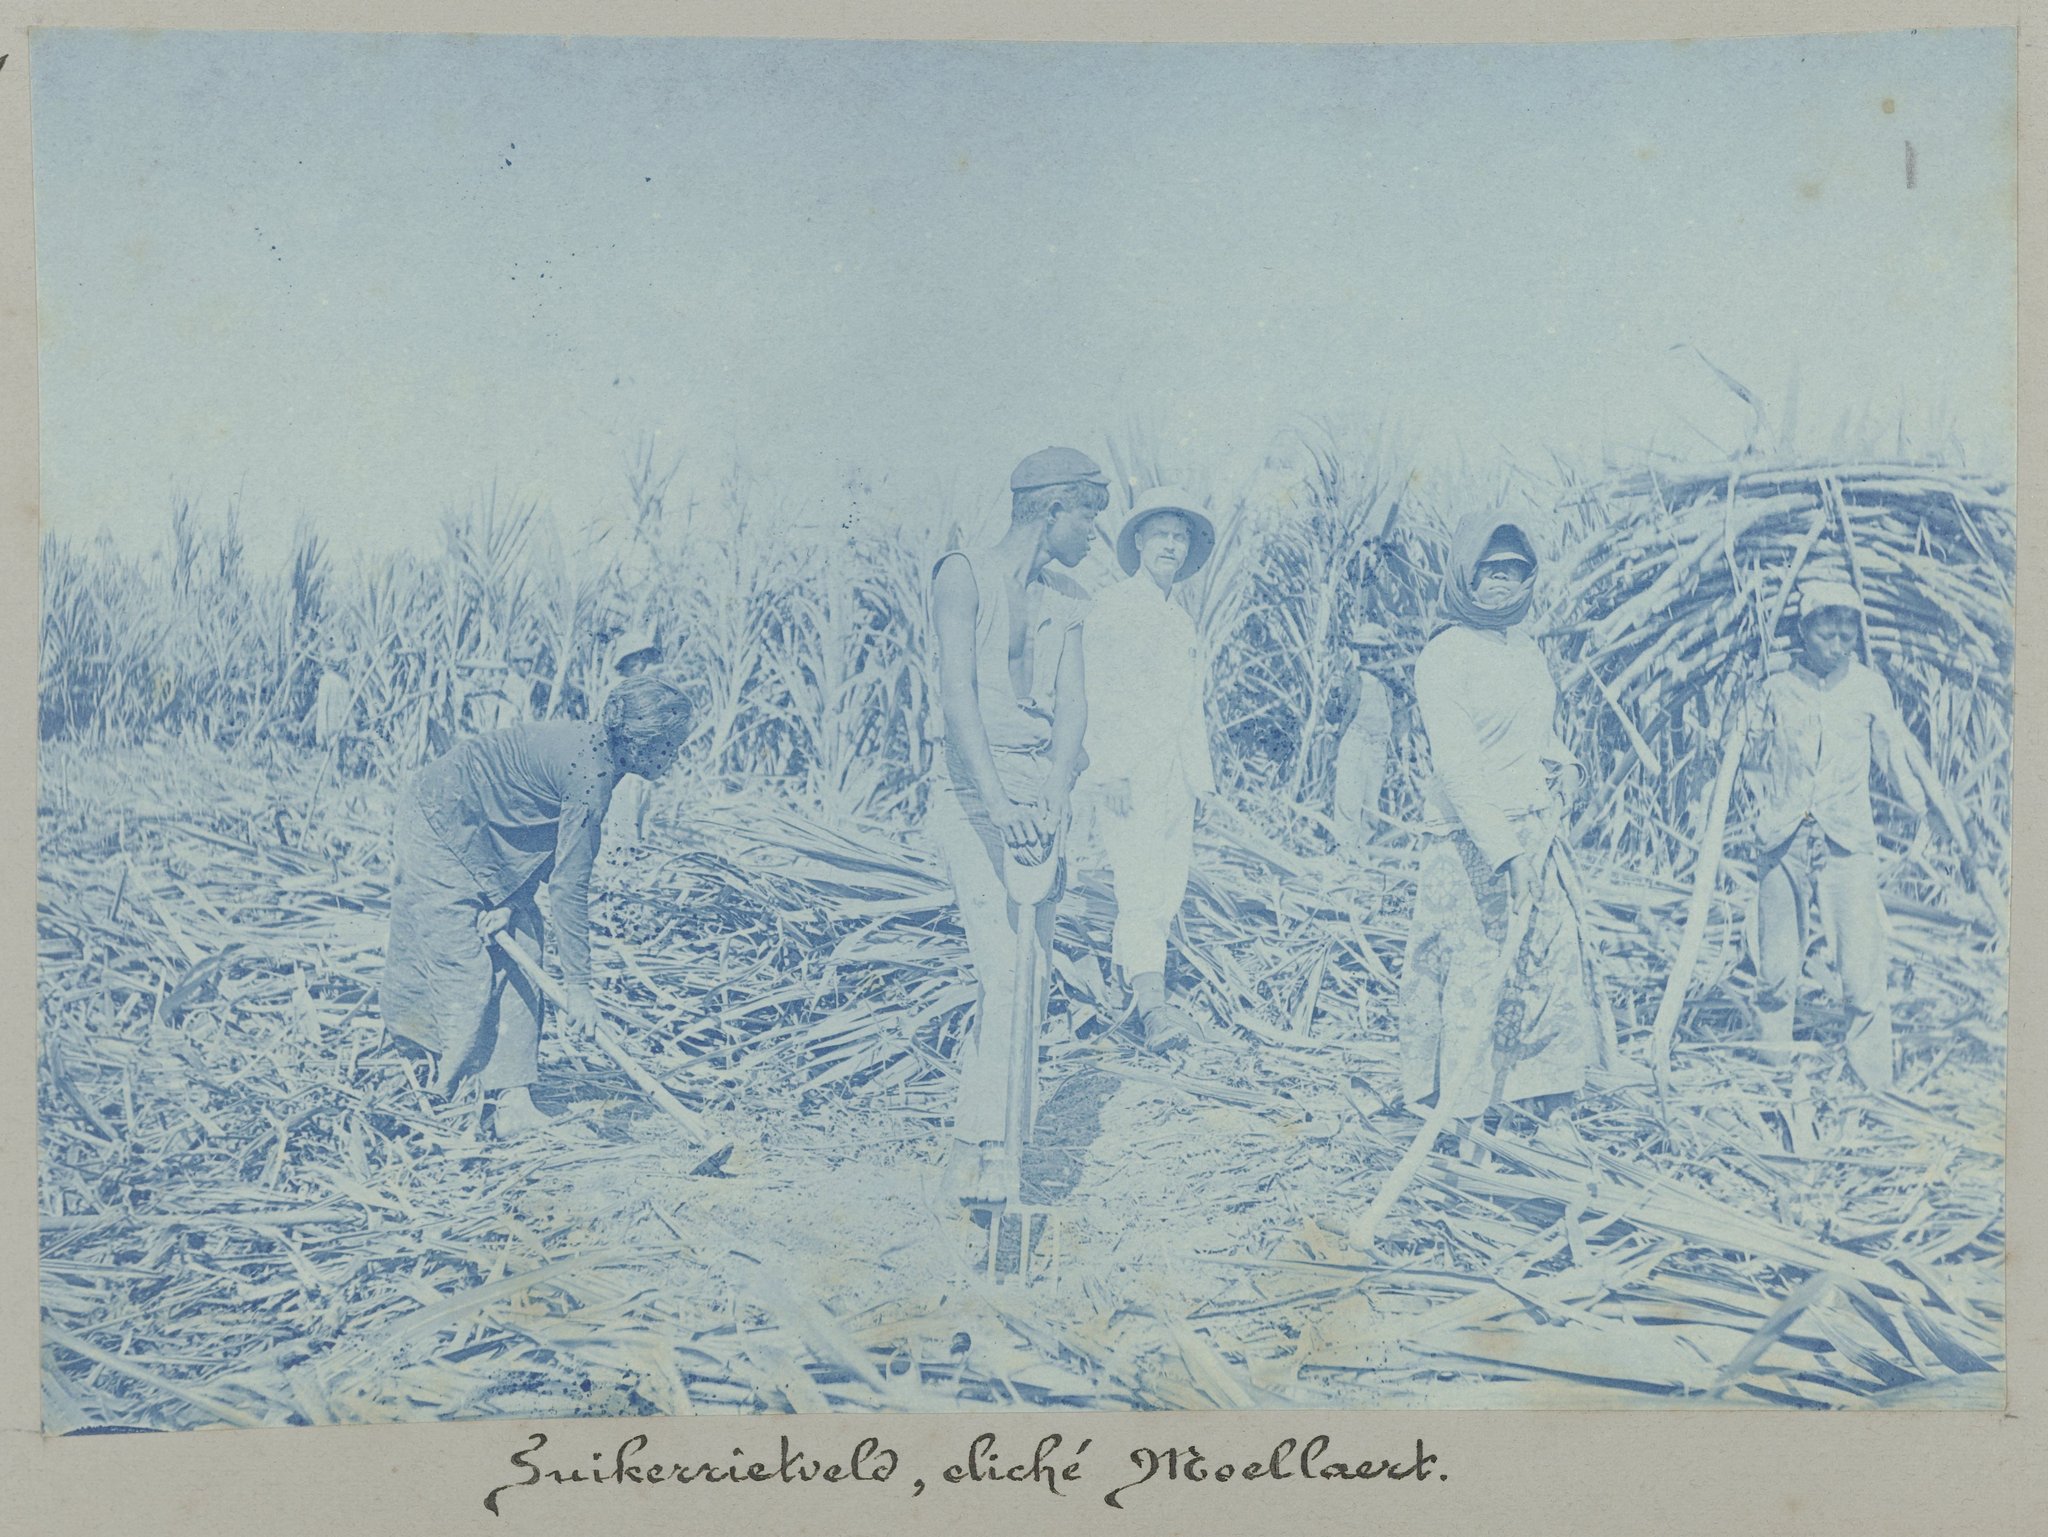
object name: photograph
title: Suikerrietveld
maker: moellaert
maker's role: fotograaf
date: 1906-1913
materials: photographic support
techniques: cyanotype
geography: suriname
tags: suriname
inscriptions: inscription: ‘E1 / Suikerrietveld, cliché Moellaert.’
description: Werkers op een veld bezig met het oogsten van suikerriet. Onderdeel van het fotoalbum Souvenir de Voyage (deel 4), over het leven van de familie Dooyer in en rond de plantage Ma Retraite in Suriname in de jaren 1906-1913.